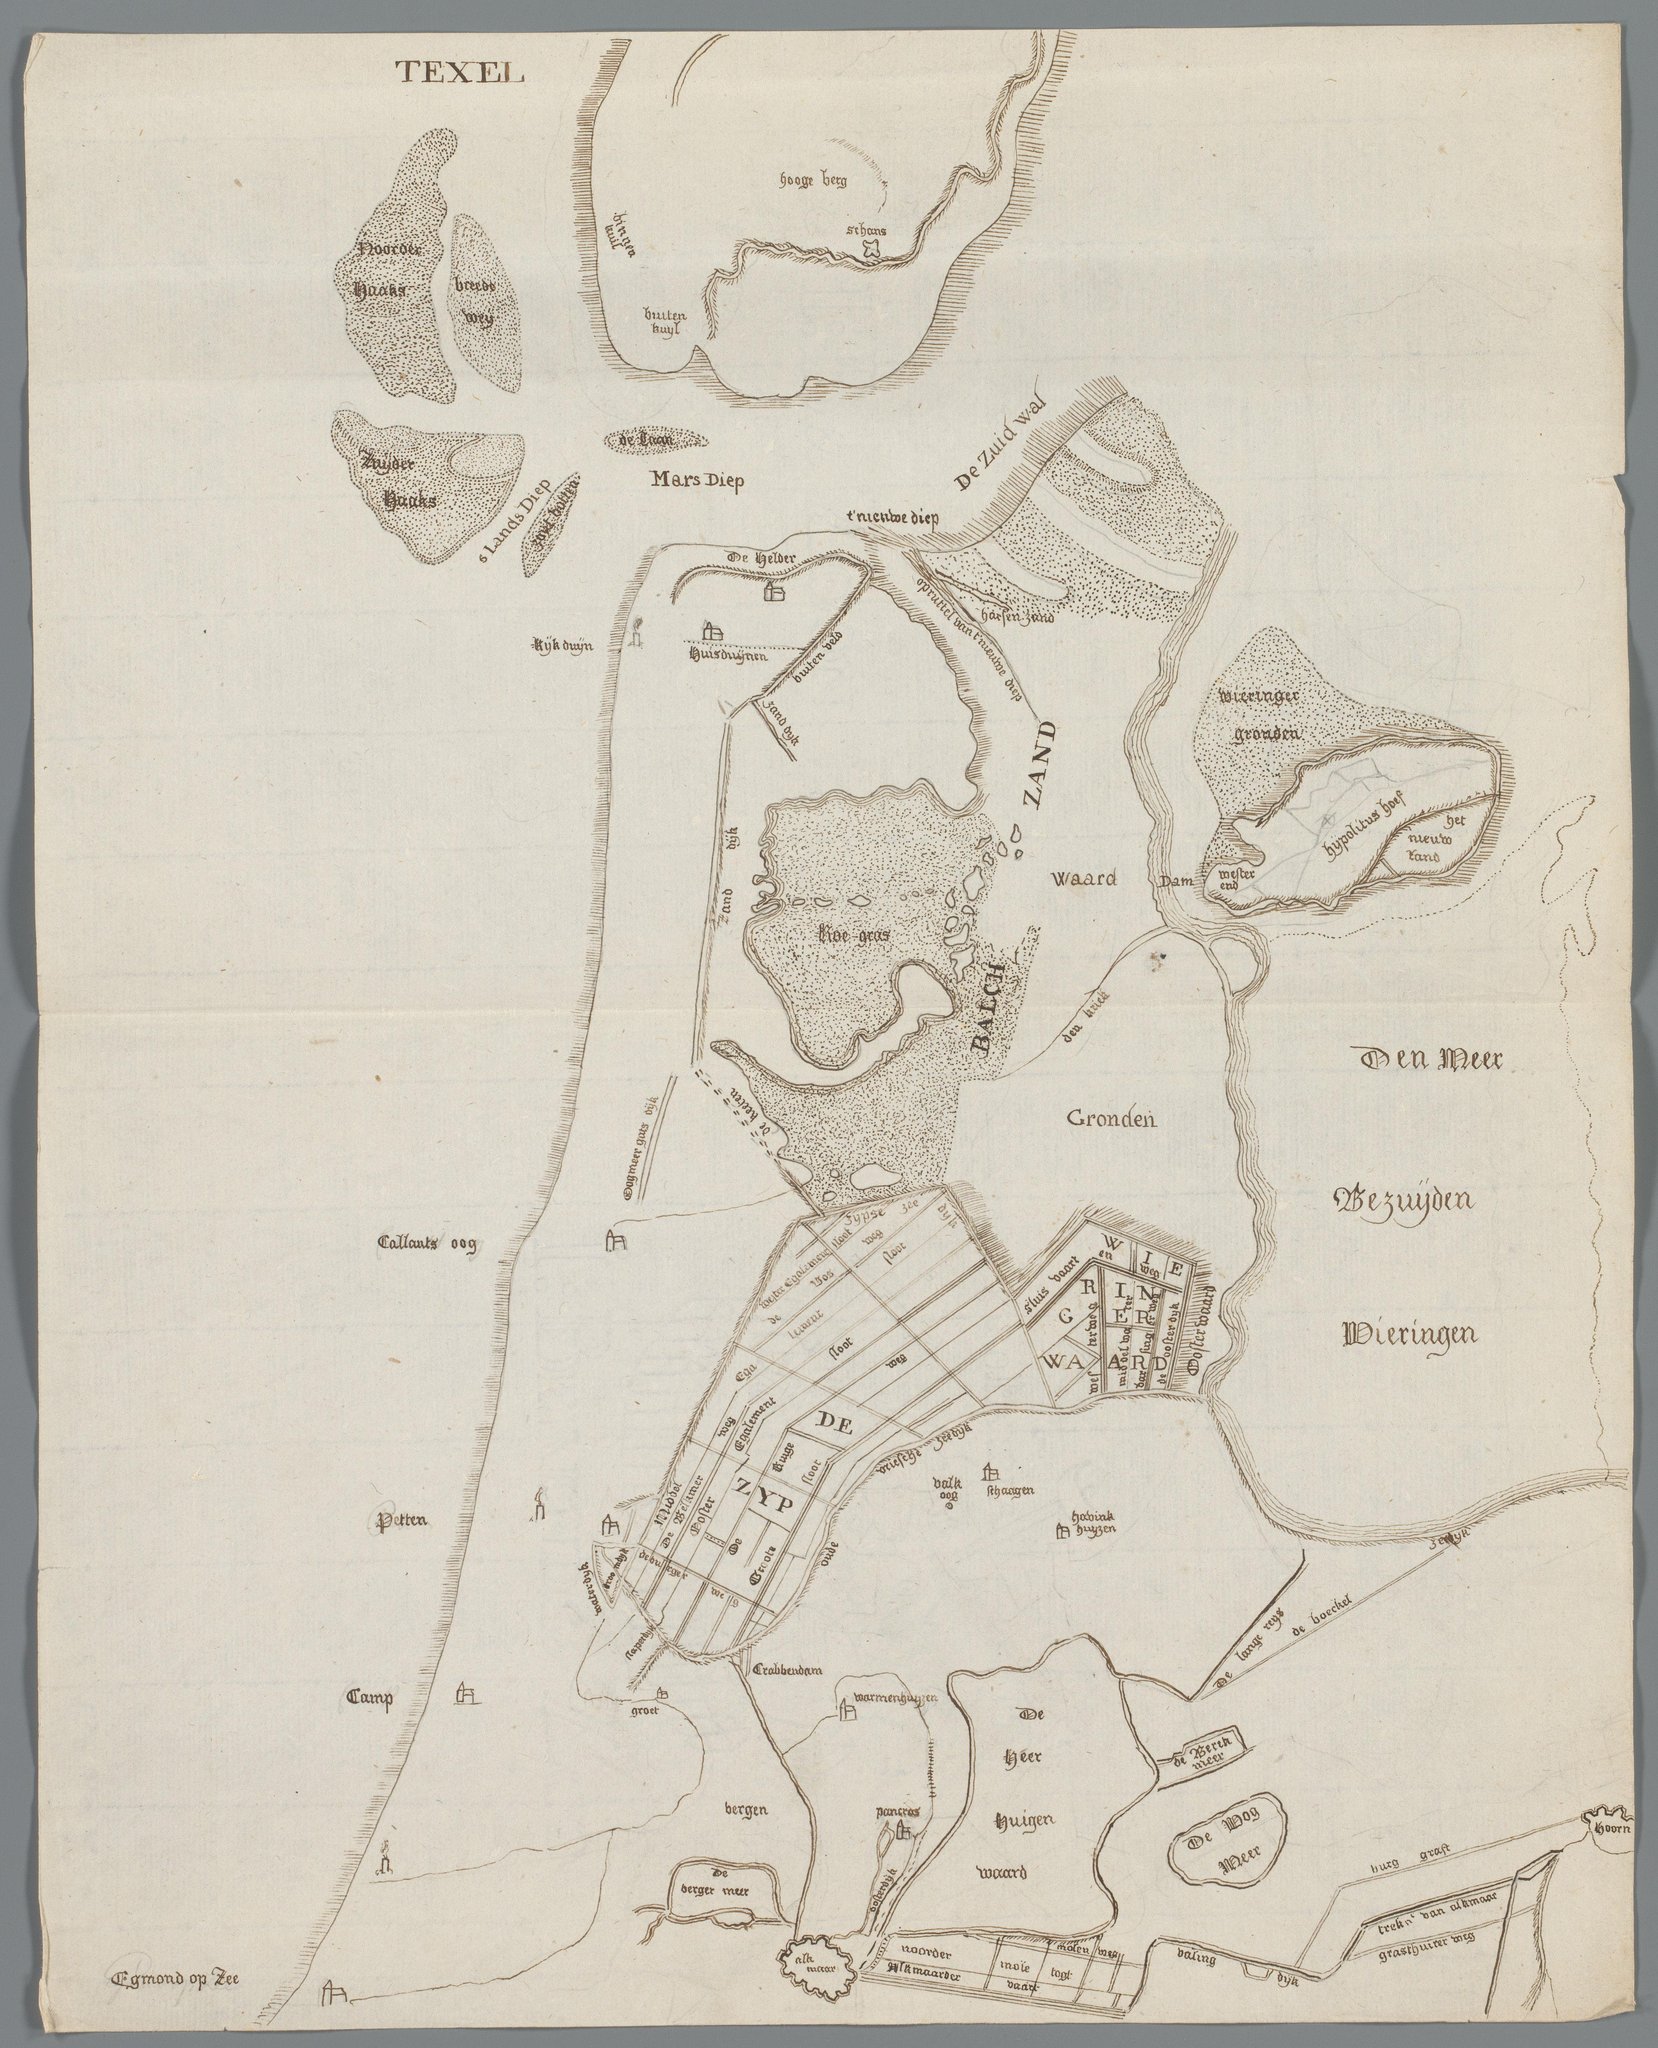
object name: map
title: Kaart van Noord-Holland, ca. 1799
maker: hendrik van der poth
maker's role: draughtsman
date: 1799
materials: paper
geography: netherlands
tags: noord-holland, brits-russische expeditie naar noord-holland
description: Getekende kaart van de kop van Noord-Holland, van Egmond aan Zee tot en met de zuidpunt van Texel, ten tijde van de Brits-Russische expeditie in 1799.